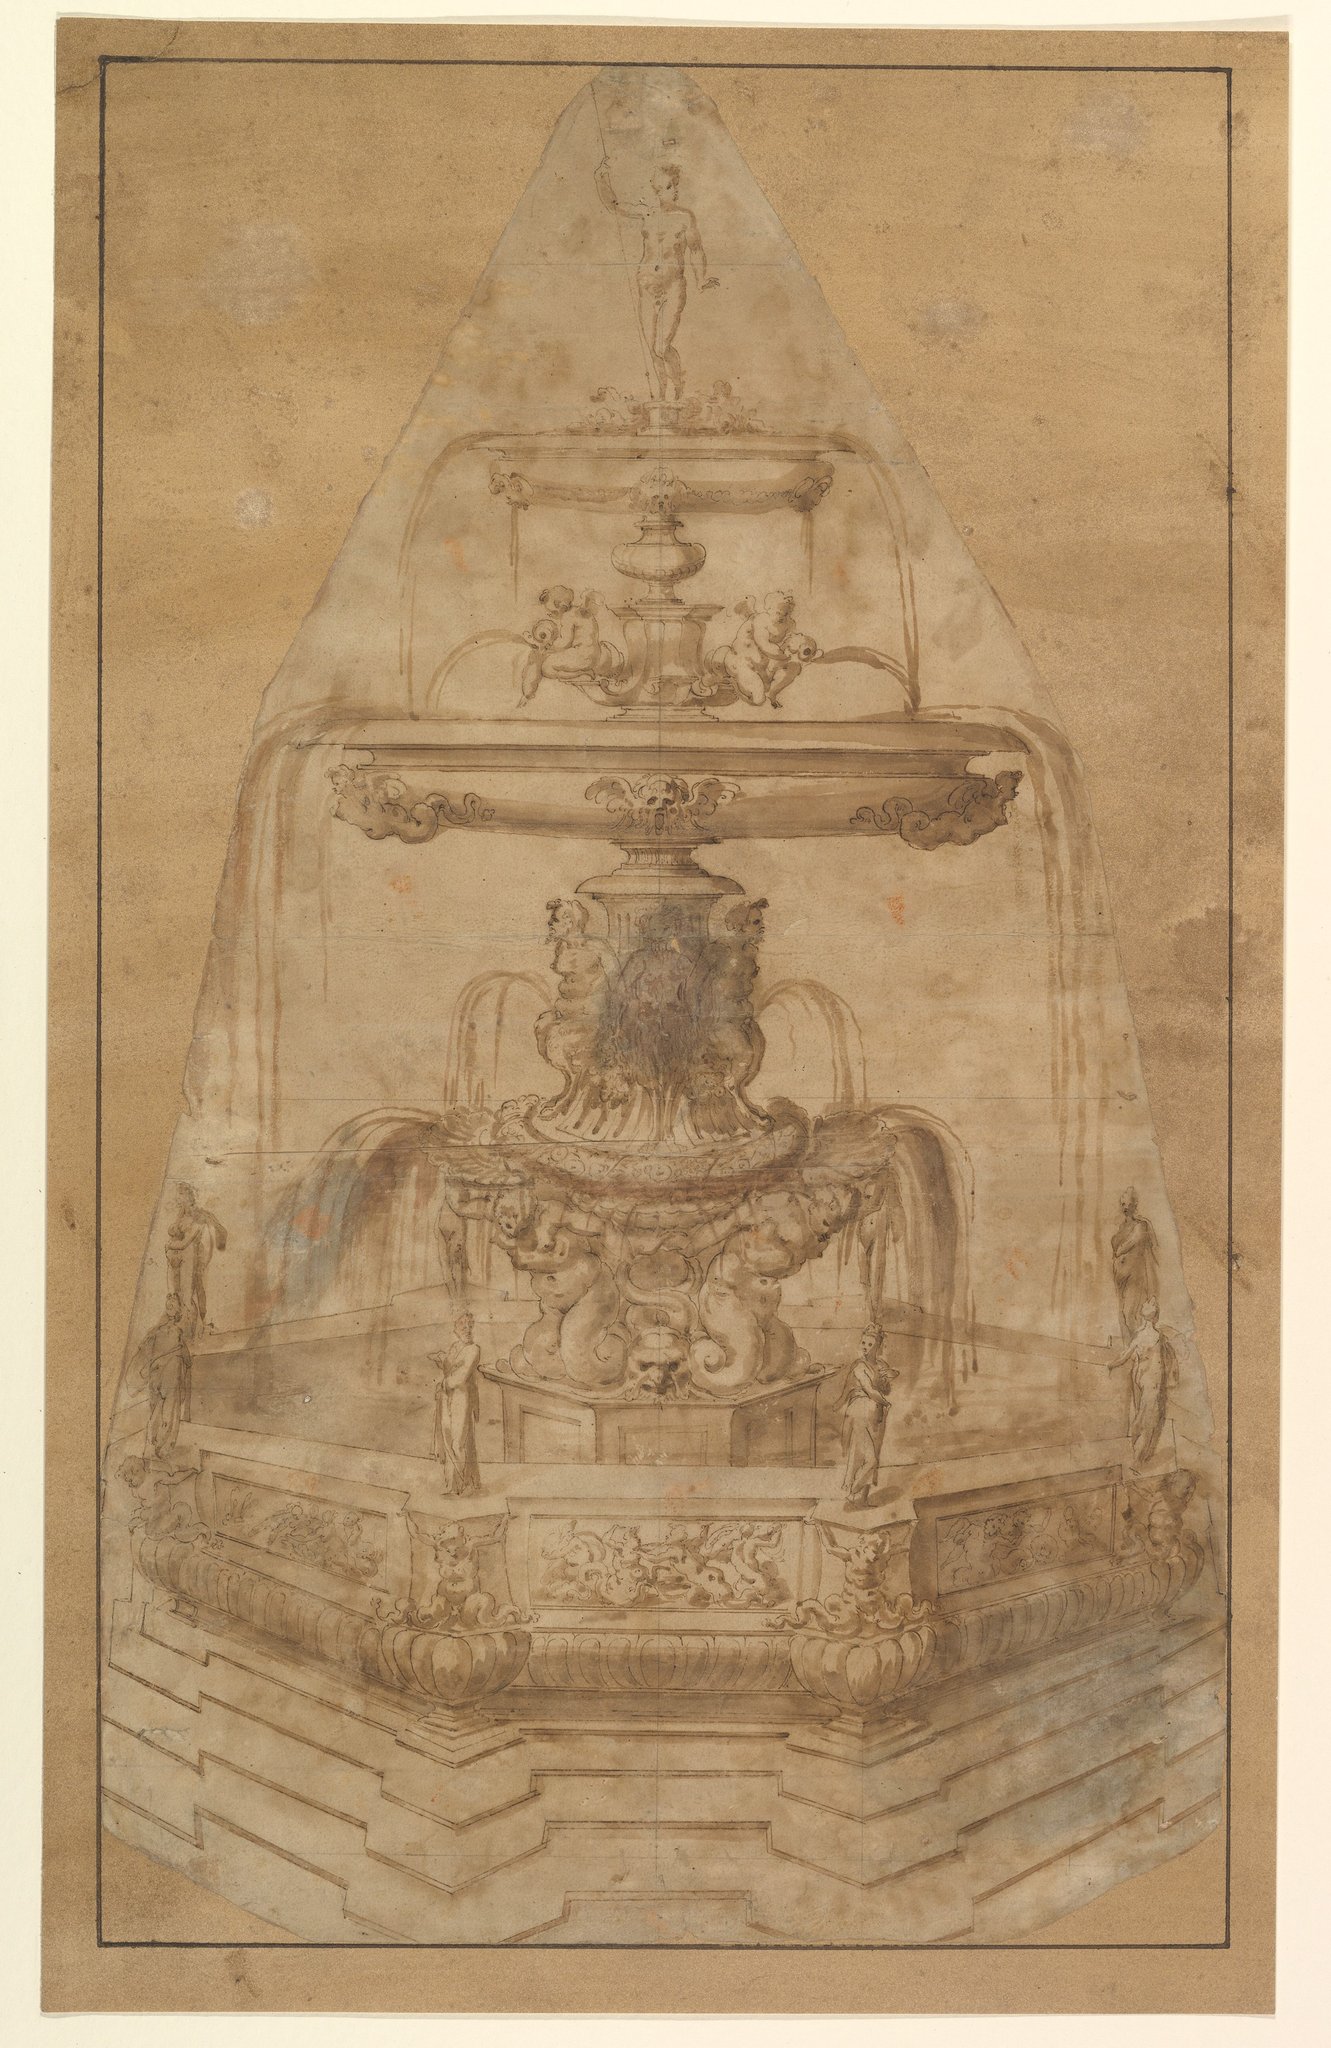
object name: drawing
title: Design for a Fountain with River Gods and Nymphs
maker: anonymous, italian, 16th century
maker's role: artist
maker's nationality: italian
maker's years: 1500-1600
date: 1501-1600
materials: chalk, ink, paper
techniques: brush, pen, wash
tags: fountains